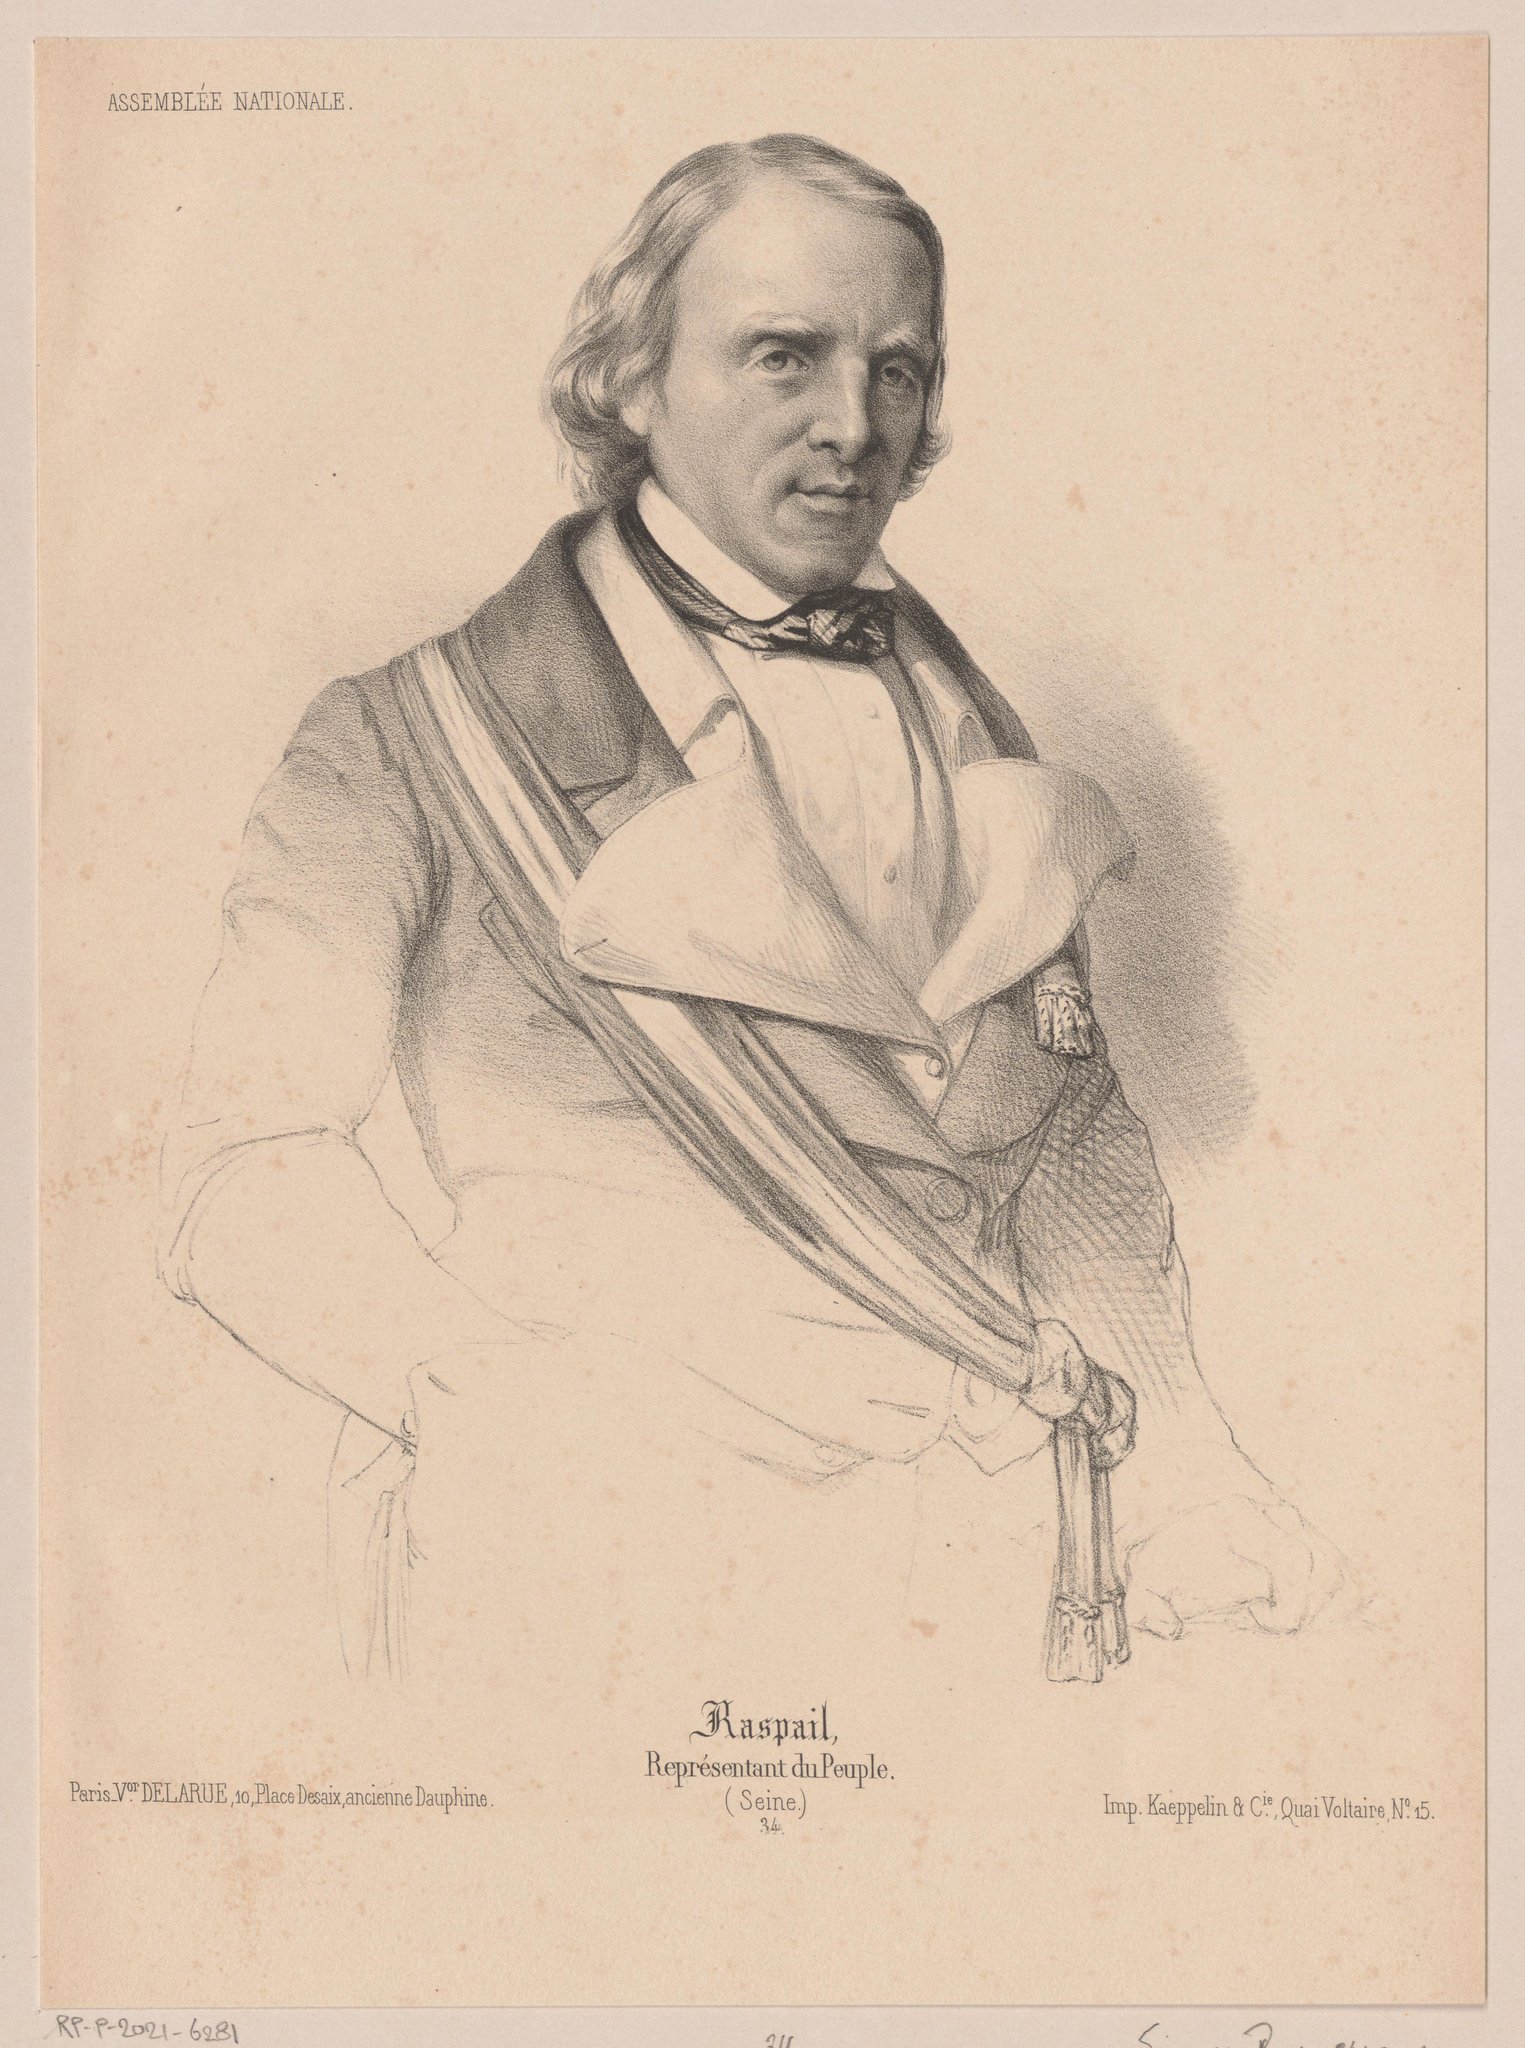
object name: print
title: Portret van François-Vincent Raspail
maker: Anonymous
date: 1830-1878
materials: paper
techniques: lithograph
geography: paris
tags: politician, historical persons